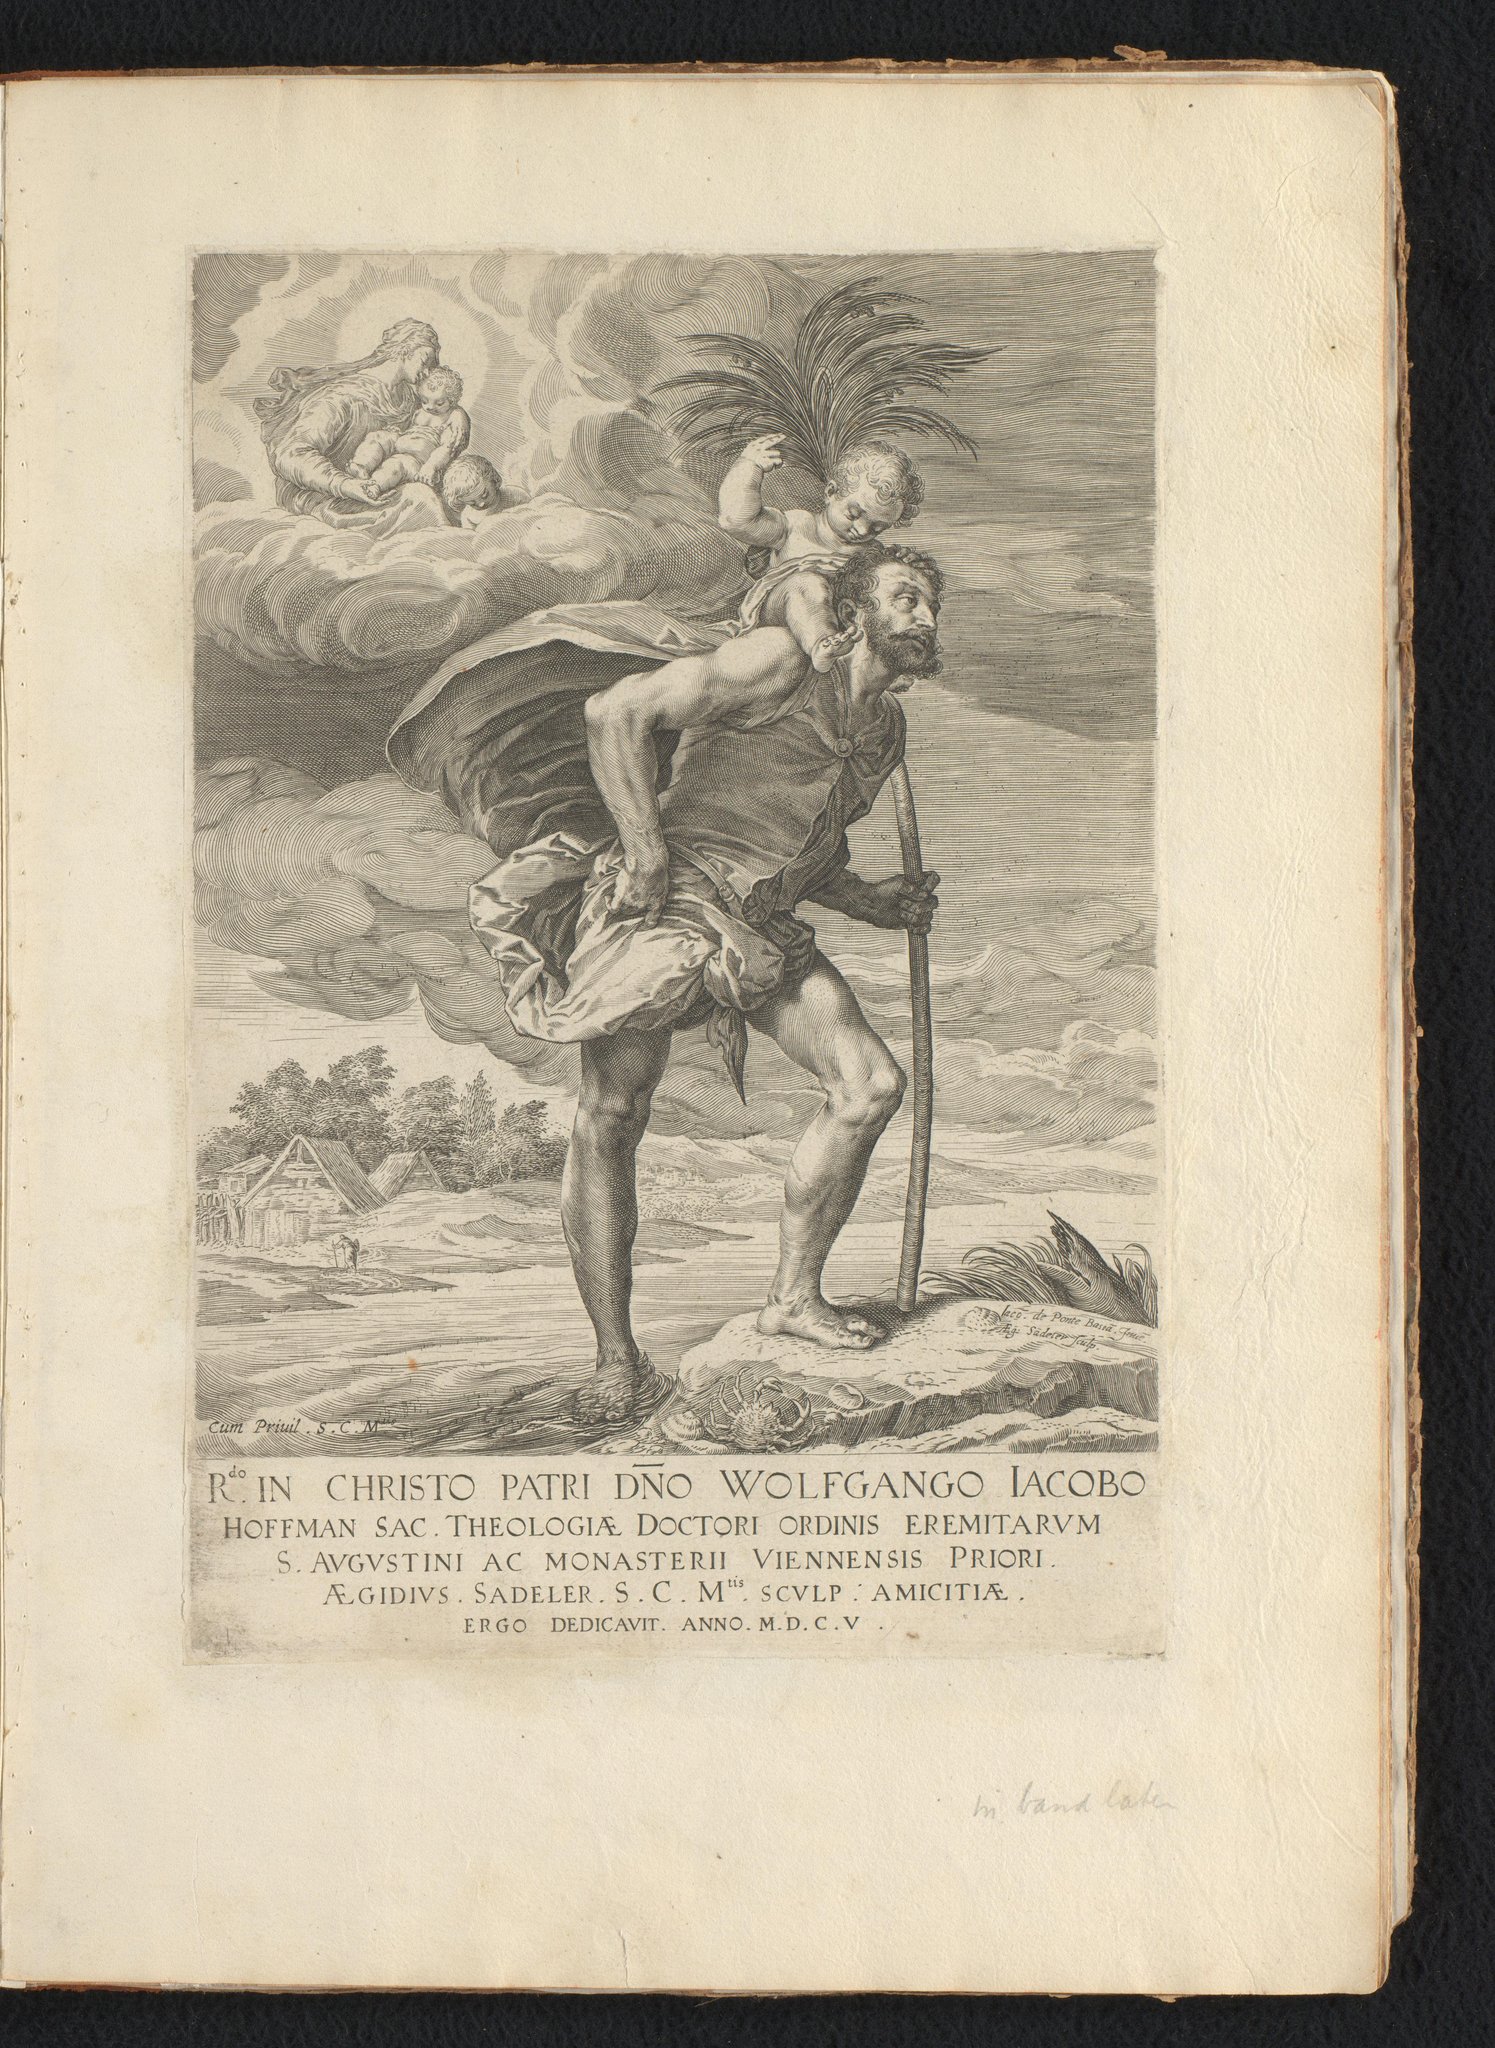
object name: print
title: H. Christoffel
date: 1605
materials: paper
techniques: engraving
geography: prague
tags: the giant and martyr christophorus; possible attributes: palm-tree (with bunches of dates, or withered), infant christ - personal devotion of male saint (+ mary)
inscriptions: signature: ‘Aeg. Sadeler sculp.’, signature: ‘Iaco. de Ponte Bassa Inven.’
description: De Heilige Christoffel draagt het Christuskind op zijn schouders over een rivier. In zijn linkerhand een palmboom als staf. Linksboven in de wolken Maria met Christuskind en Johannes de Doper. Deze prent maakt deel uit van een album.